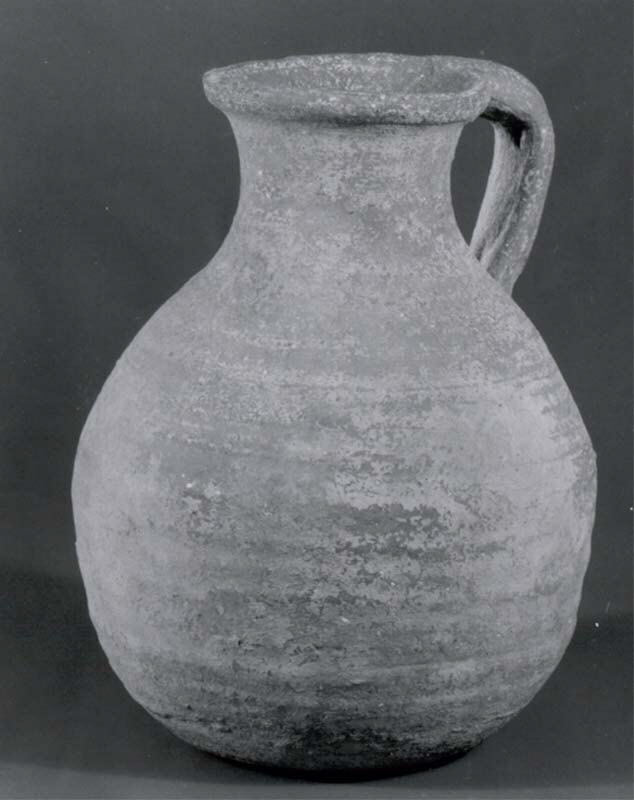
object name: juglet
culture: nabataean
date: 1-100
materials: ceramic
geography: levant